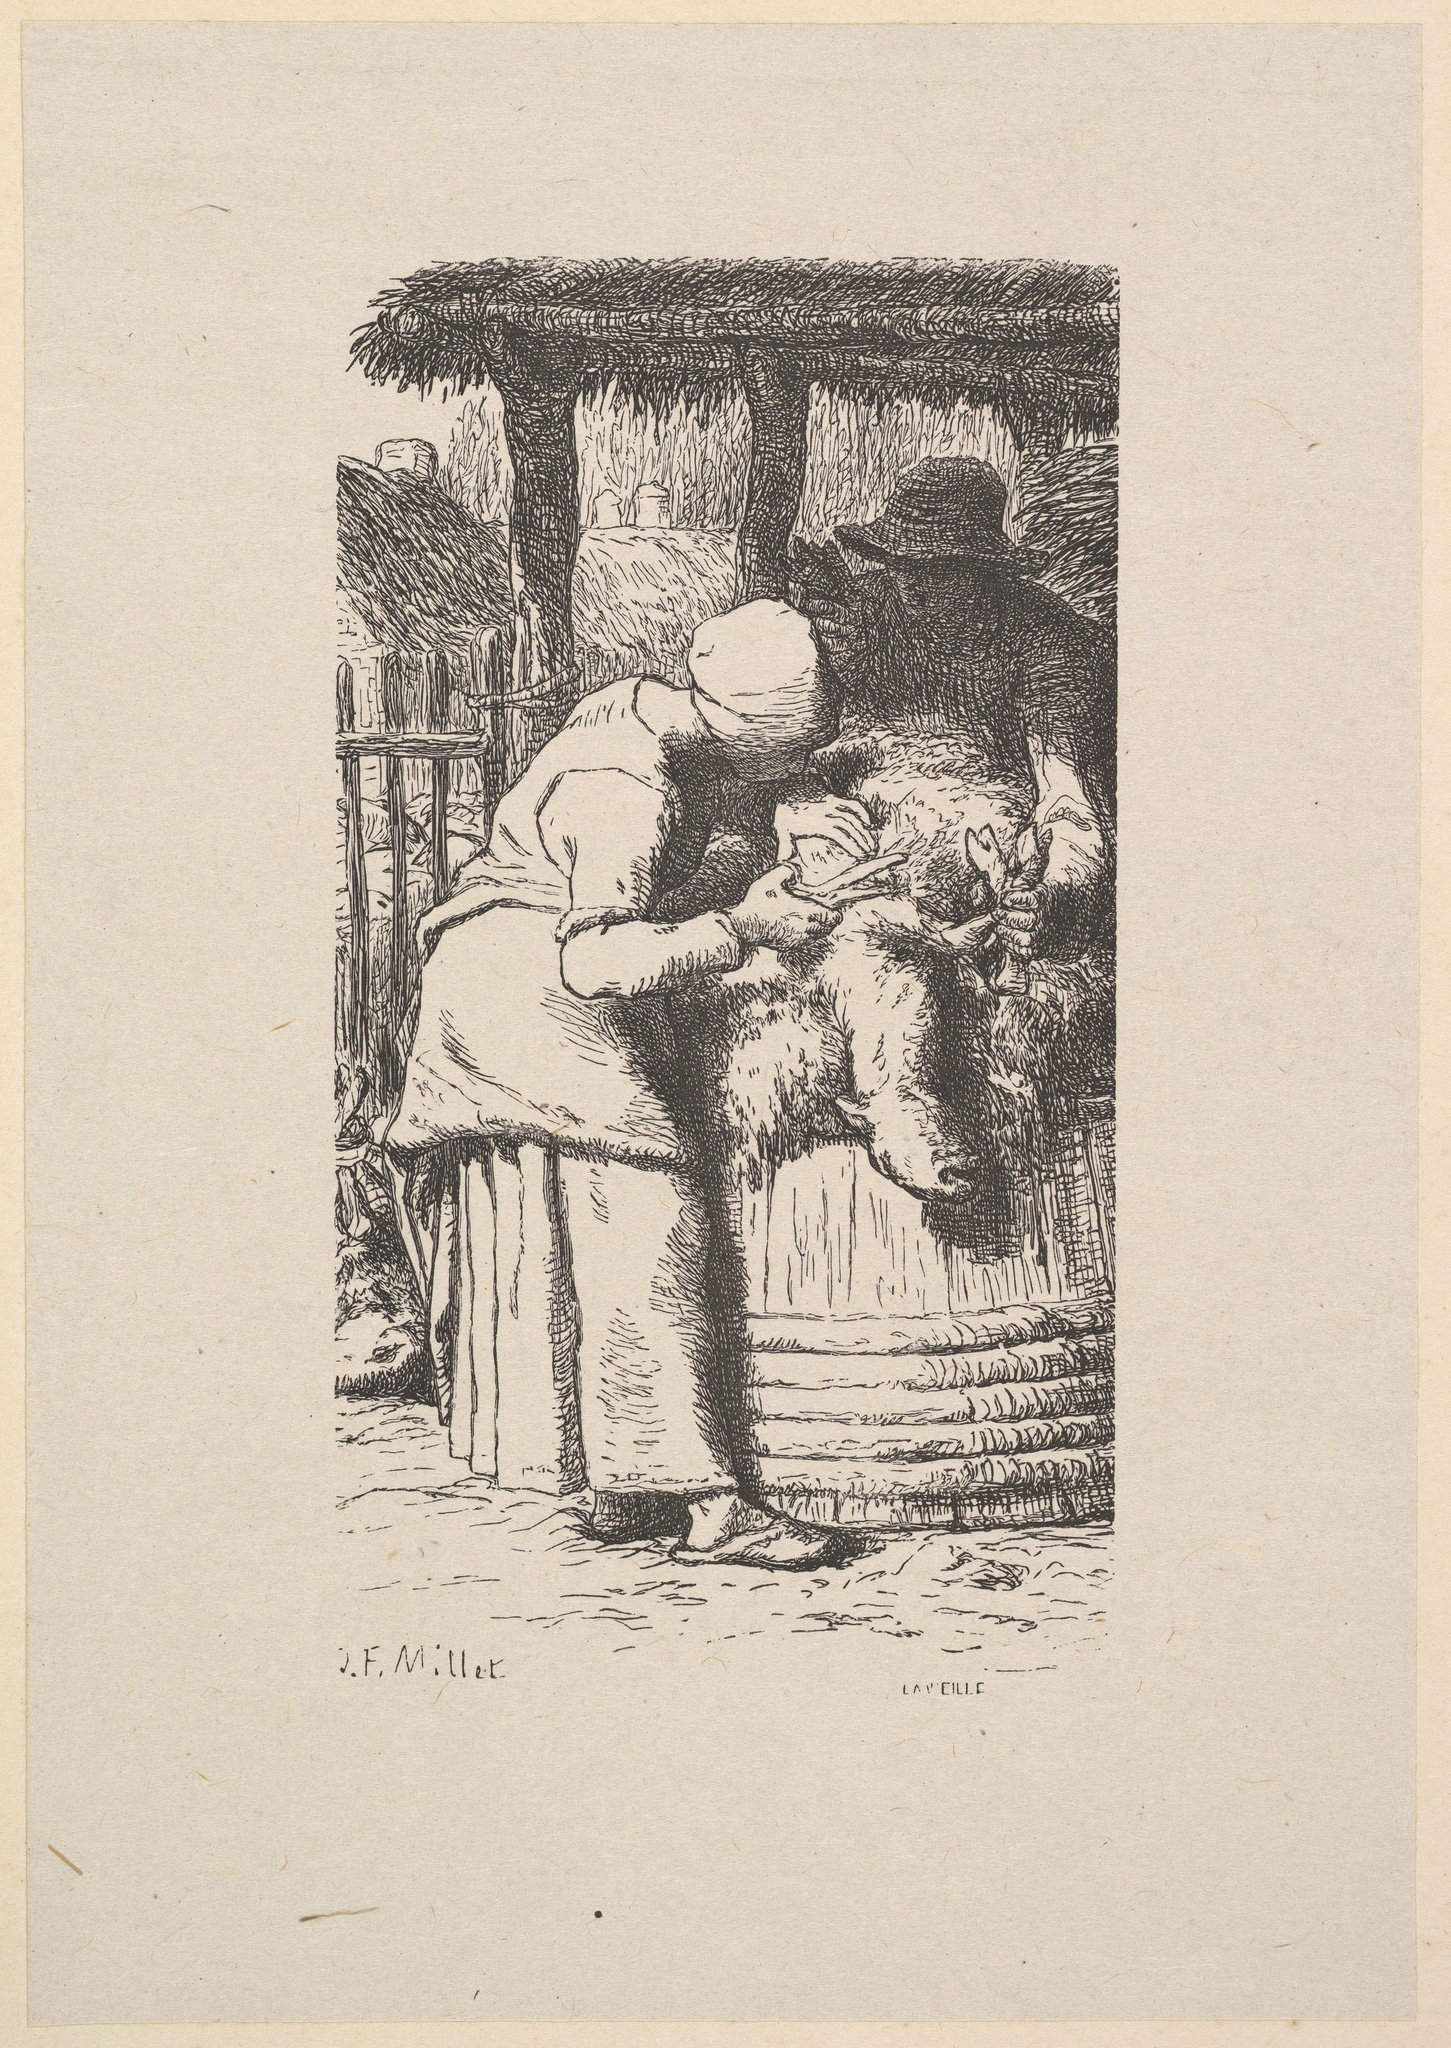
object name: print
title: Sheepshearing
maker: jean-françois millet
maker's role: artist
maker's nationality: french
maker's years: 1814-1875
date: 1853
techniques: printmaking, engraving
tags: men,women,working